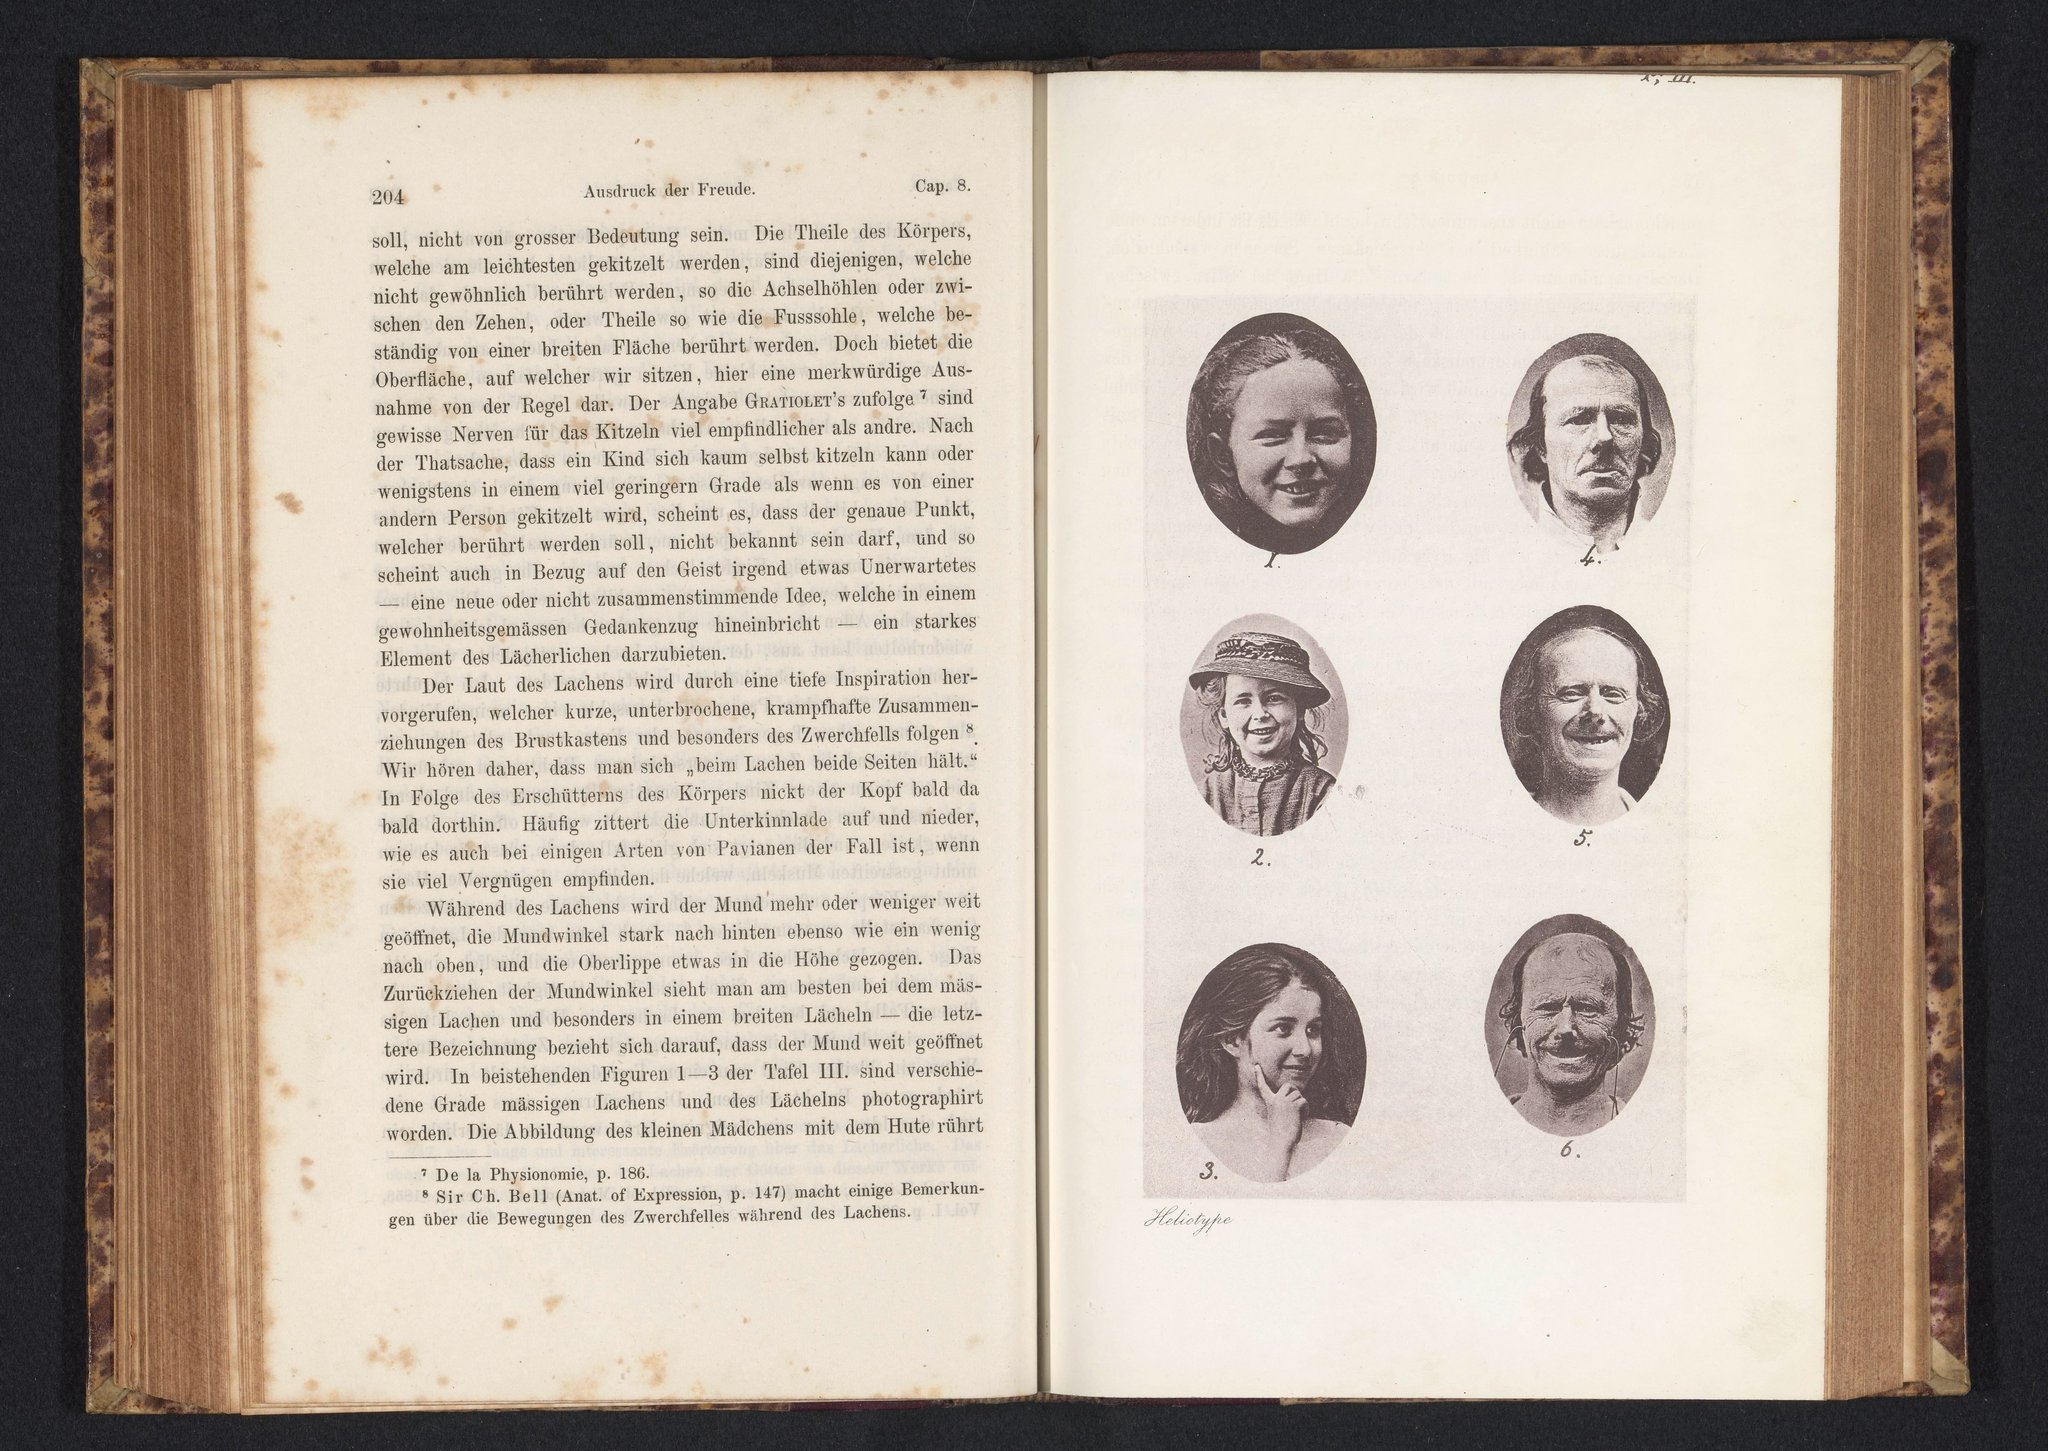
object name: page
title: Zes portretten van onbekende mensen en kinderen die vreugde tonen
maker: Anonymous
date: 1862-1872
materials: paper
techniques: photoaquatint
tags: passions, emotions, affections, laughing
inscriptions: number: ‘Pl. III. 1. 2. 3. 4. 5. 6.’